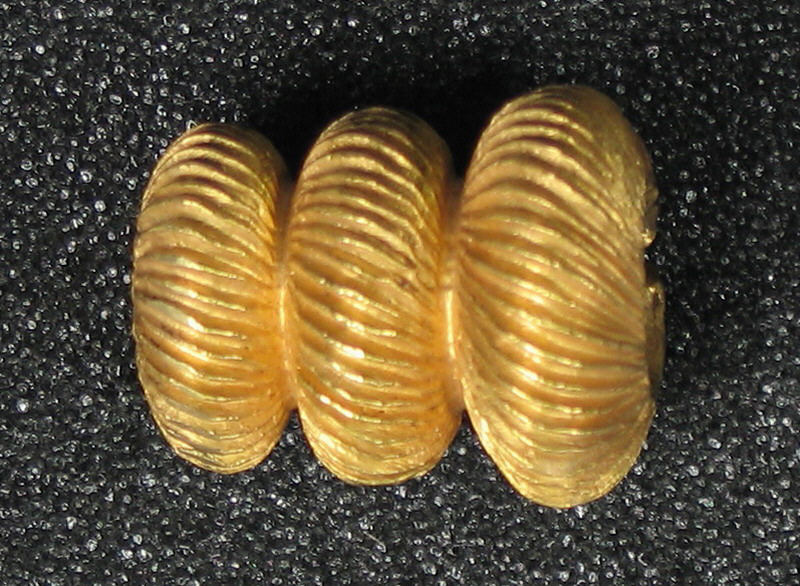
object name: earring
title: Earring, Smaller Hatched Loops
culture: indonesian, central java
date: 701-1200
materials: gold